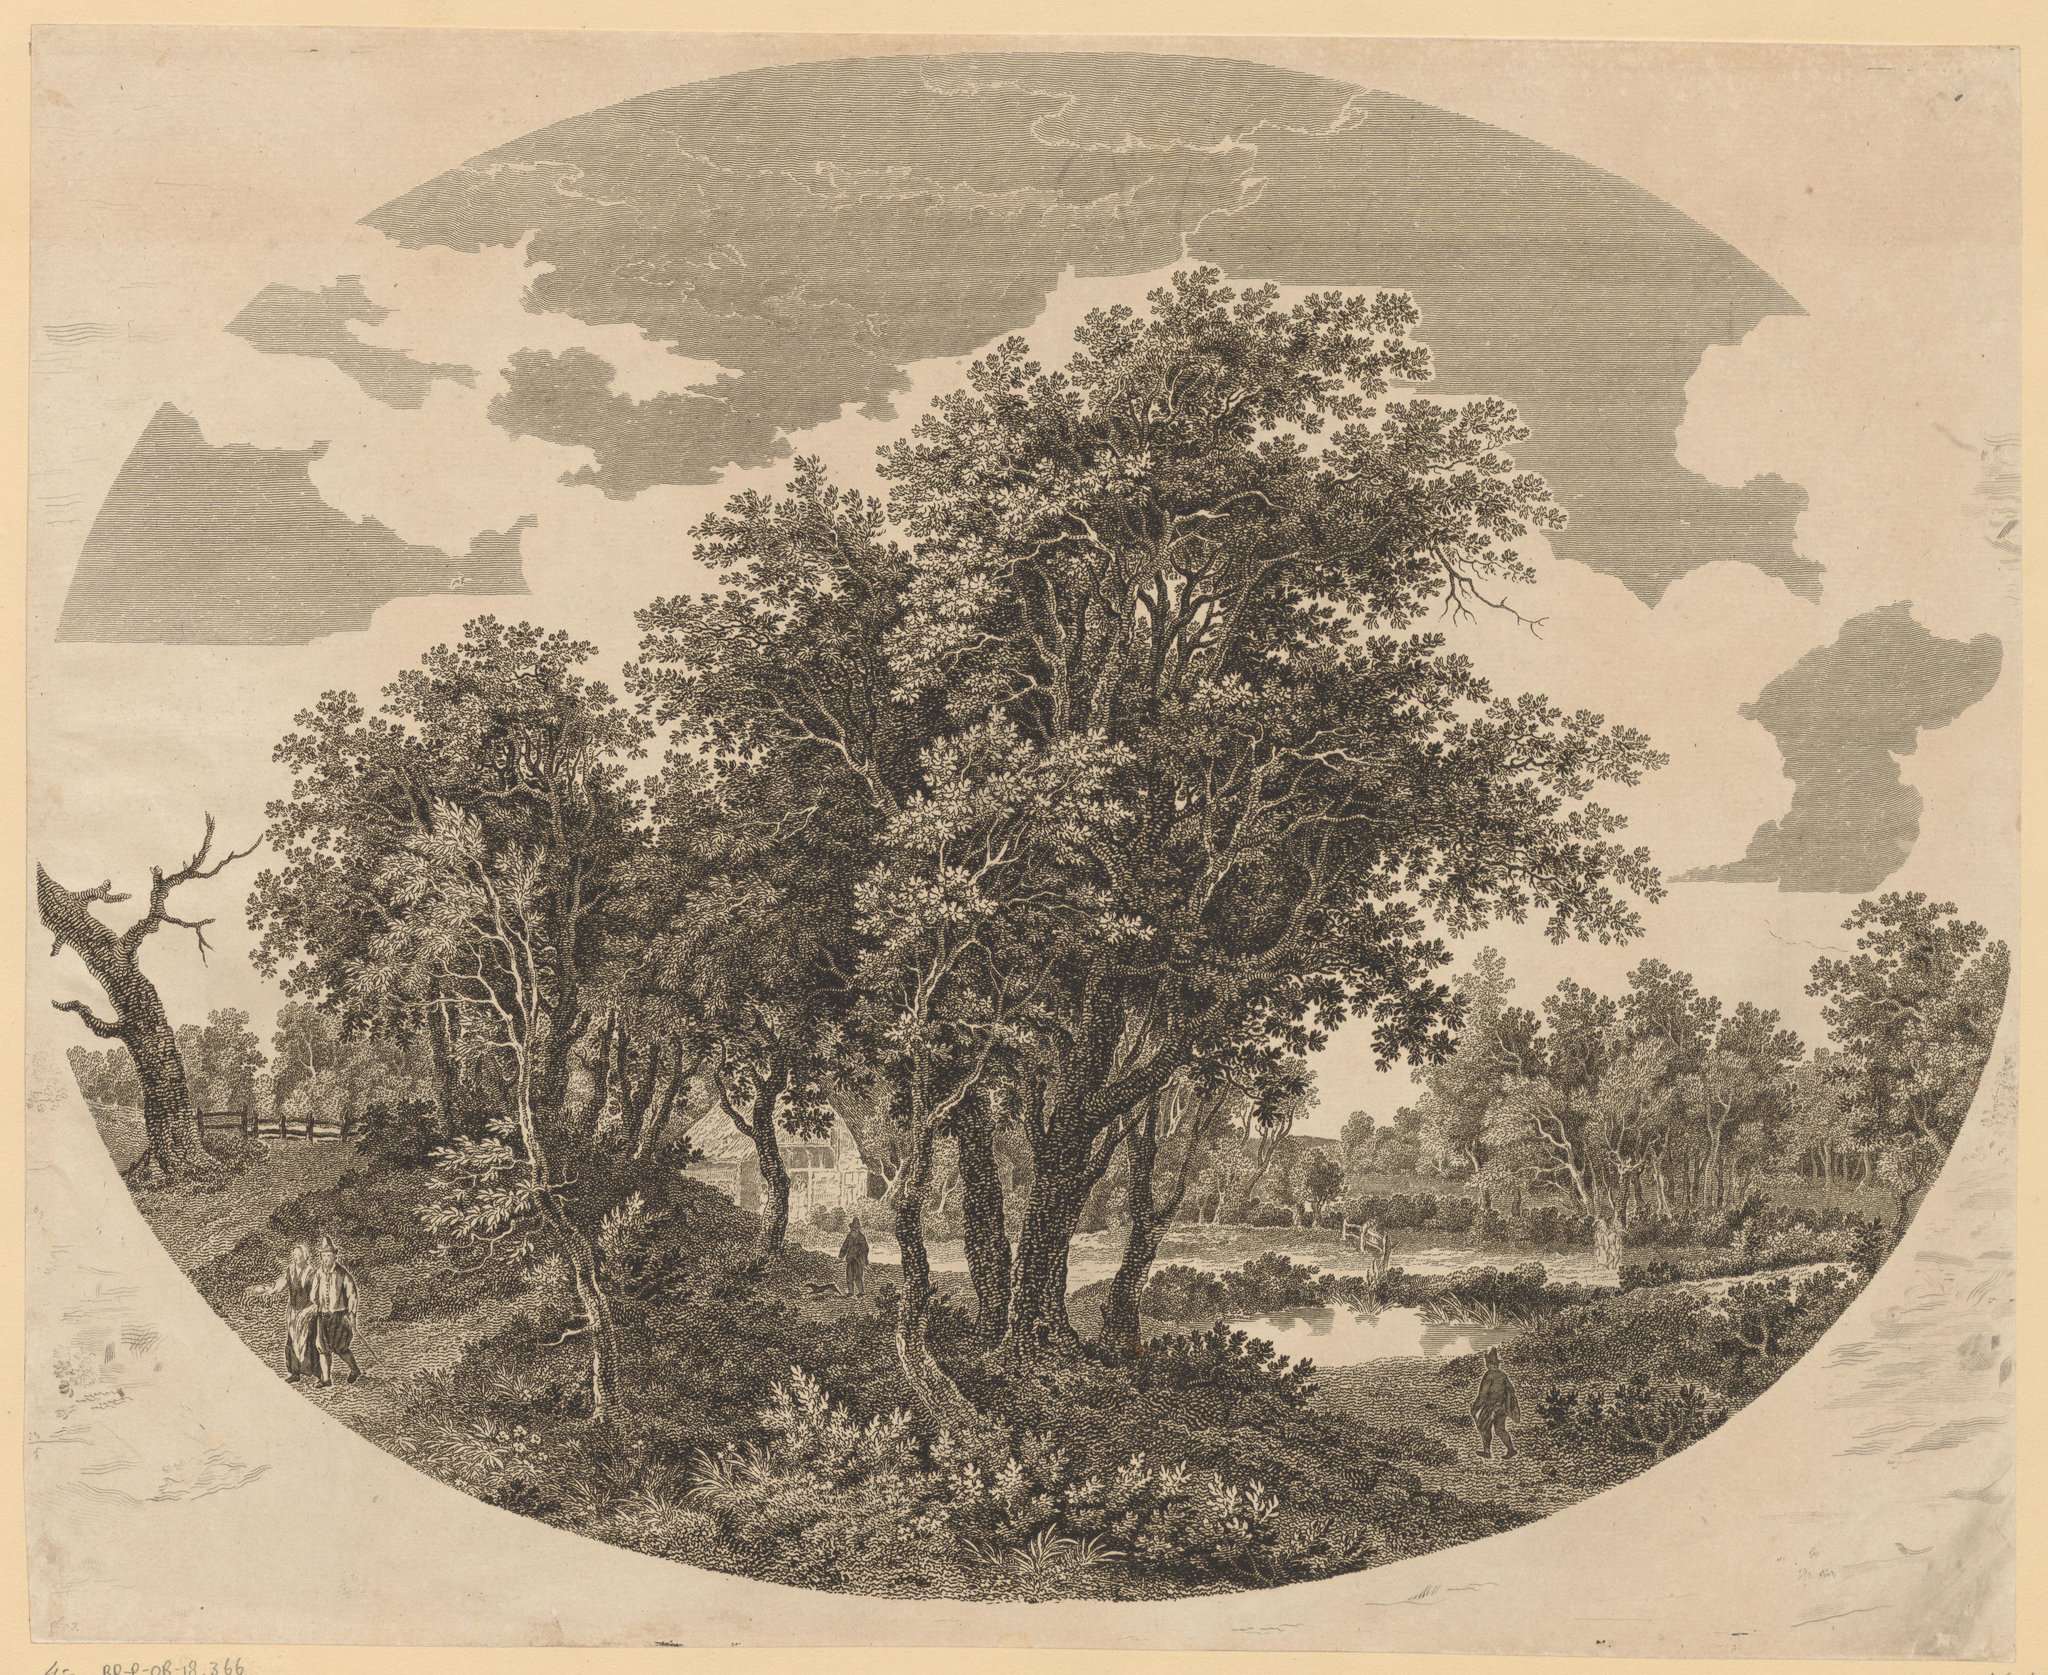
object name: print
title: The Cottage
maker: john browne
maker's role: print maker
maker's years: 1741-1801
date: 1773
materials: paper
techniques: etching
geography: london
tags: trees, walking, hiking (recreation), cottage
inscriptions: collector's mark: Lugt 12